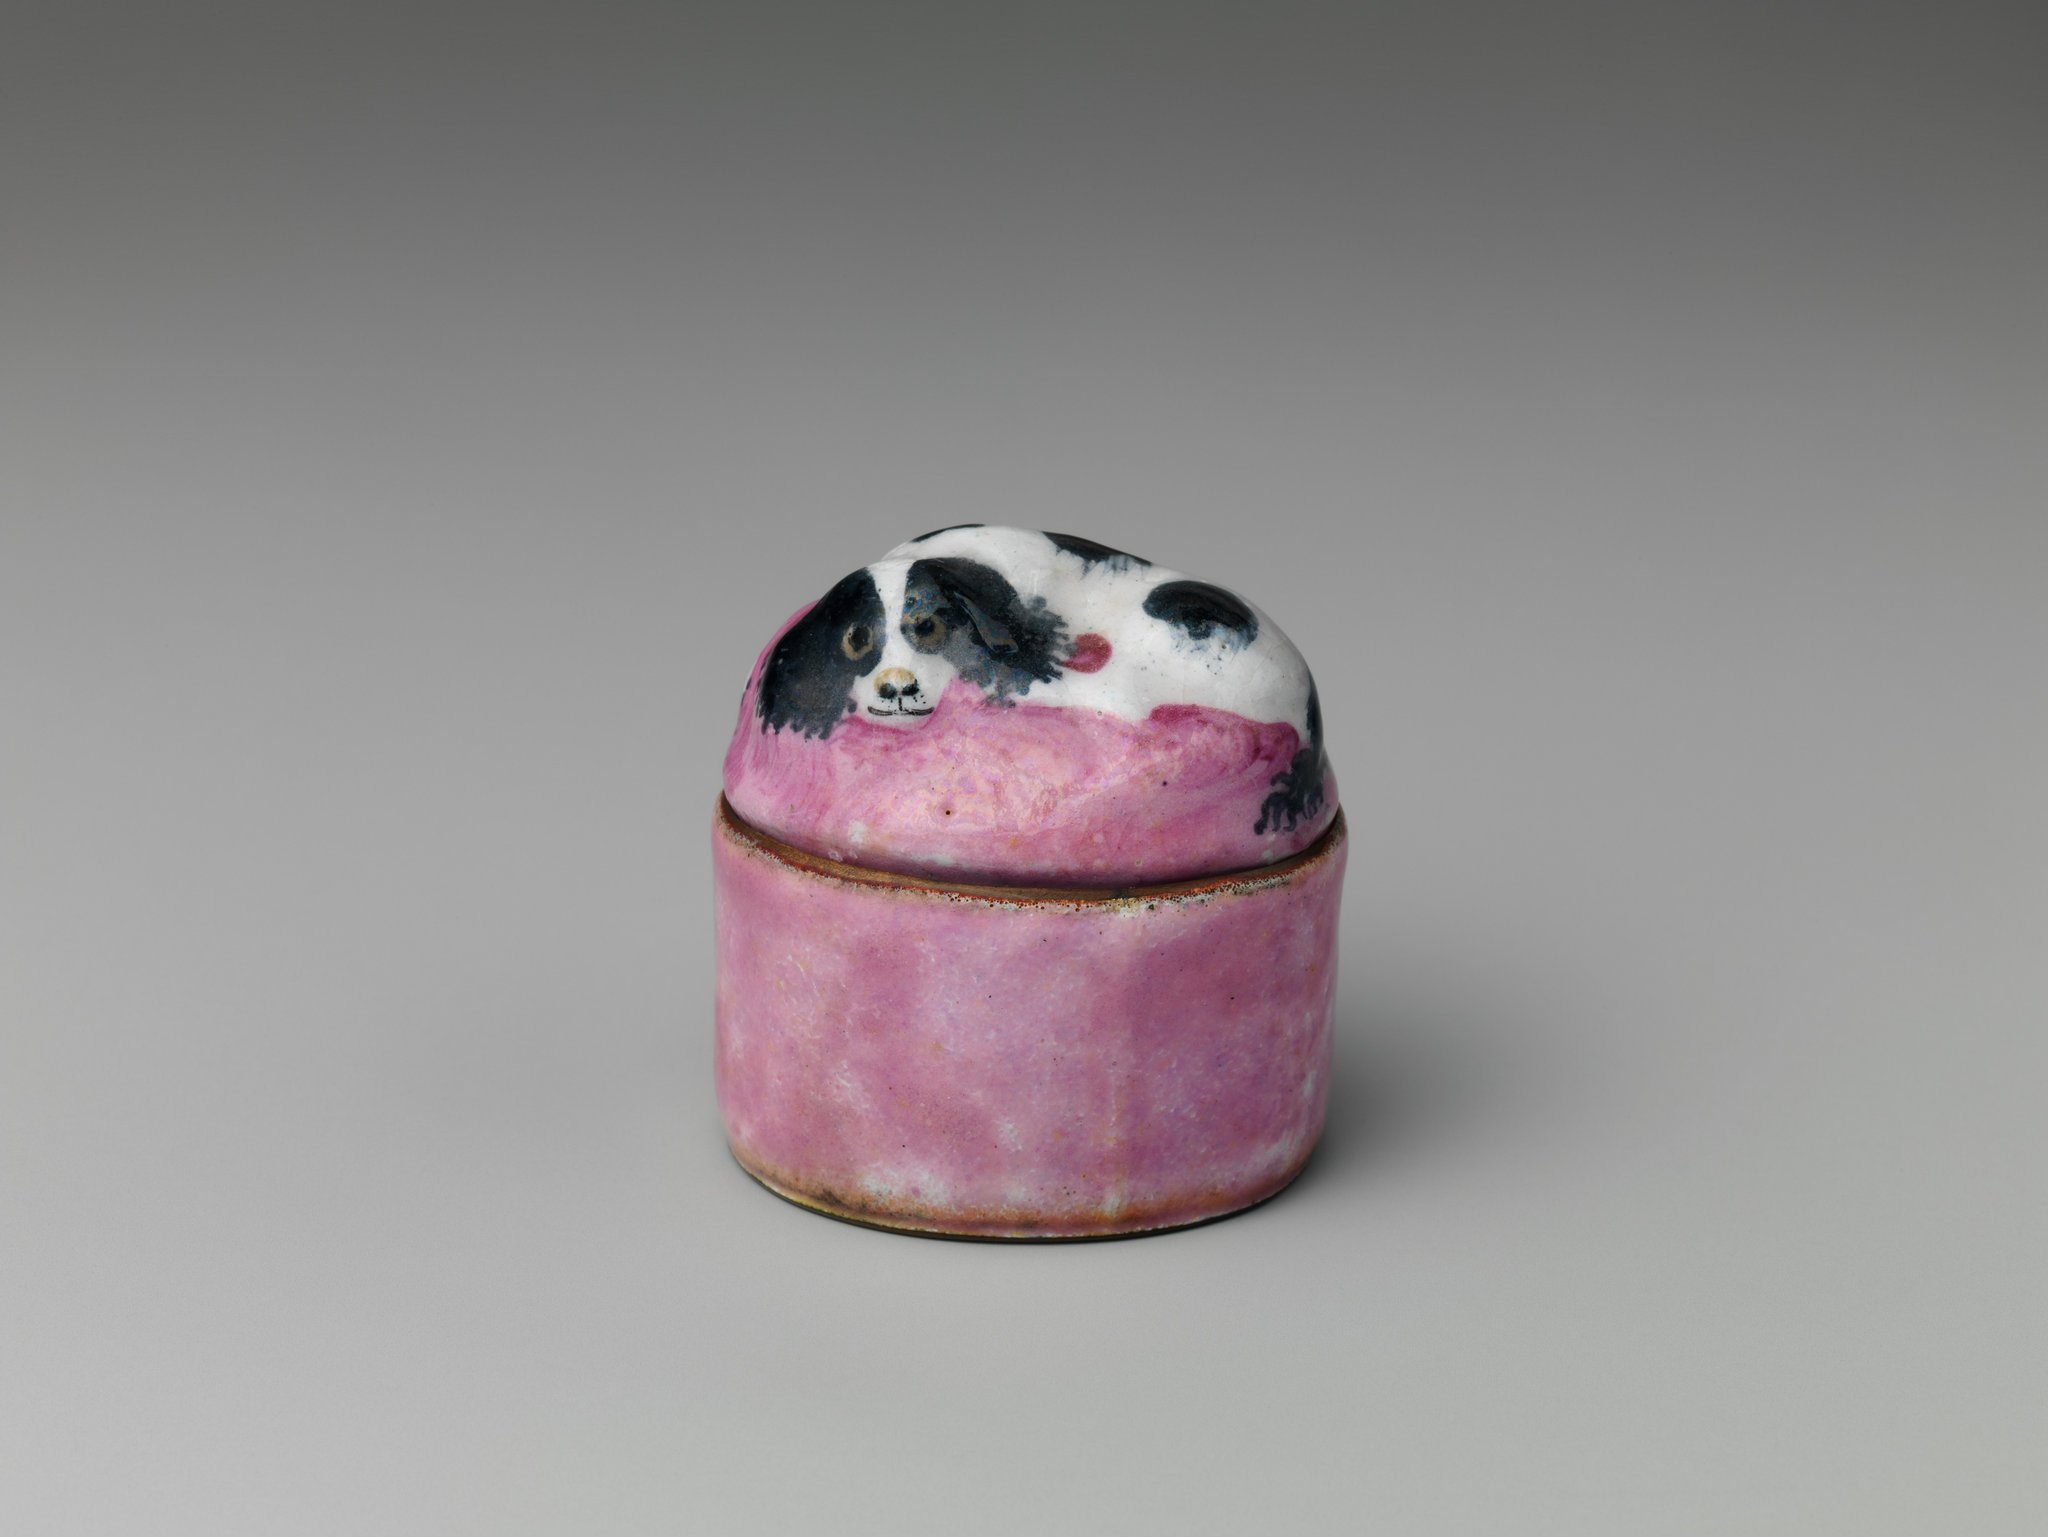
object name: bonbonnière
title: Bonbonnière with King Charles Spaniel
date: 1801-1833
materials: copper, enamel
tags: dogs